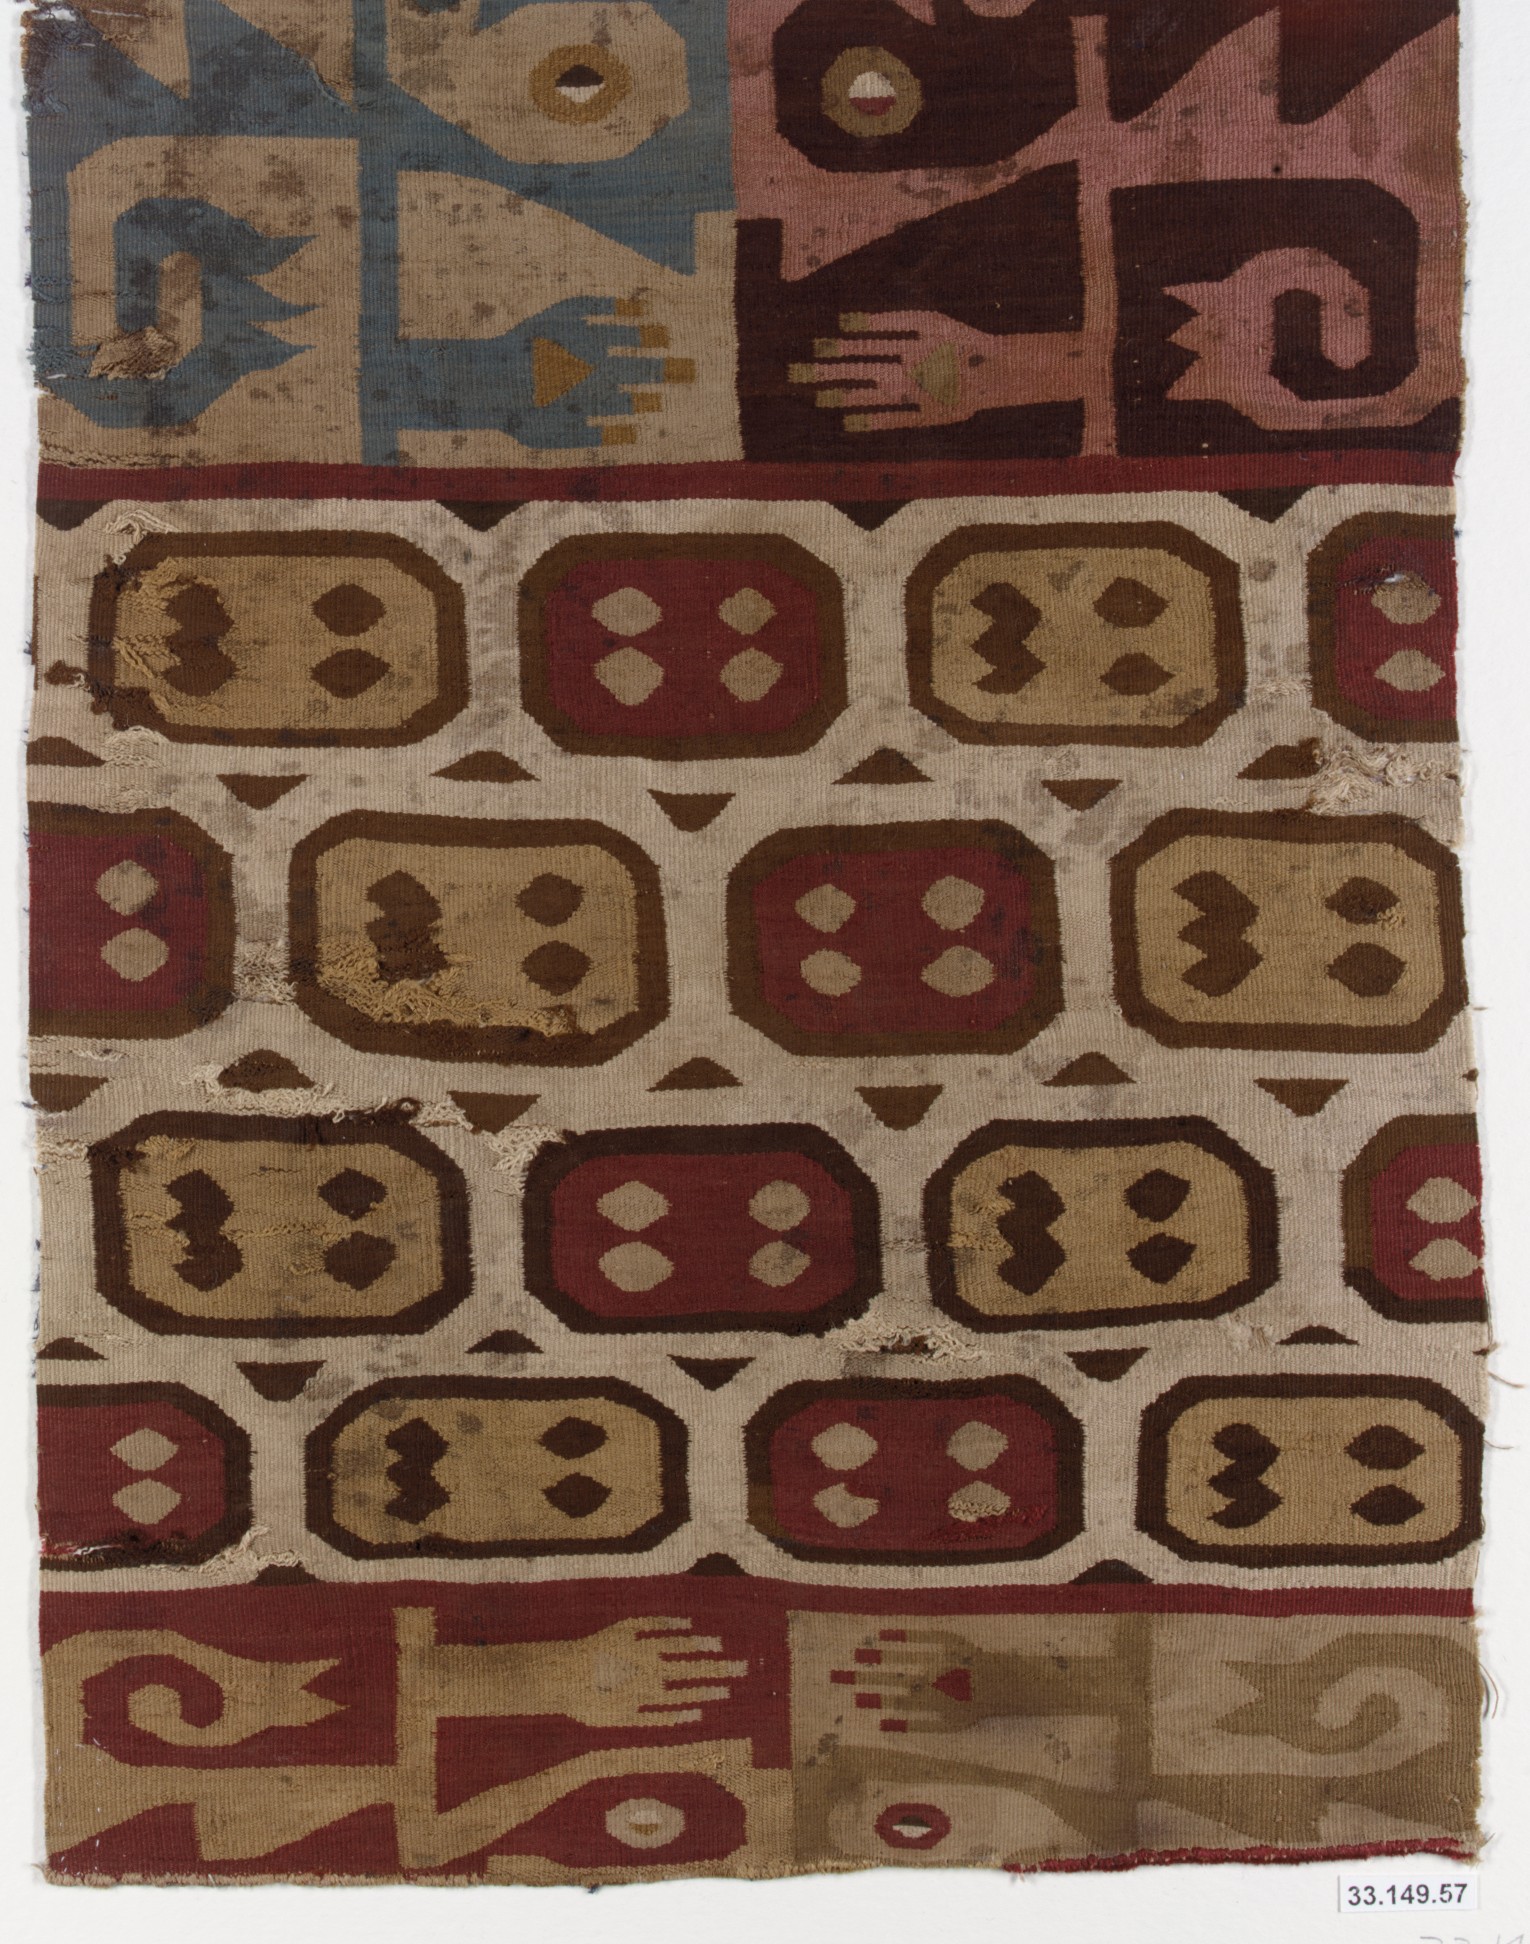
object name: tunic fragment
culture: wari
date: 601-900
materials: animal fiber, cotton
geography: peru